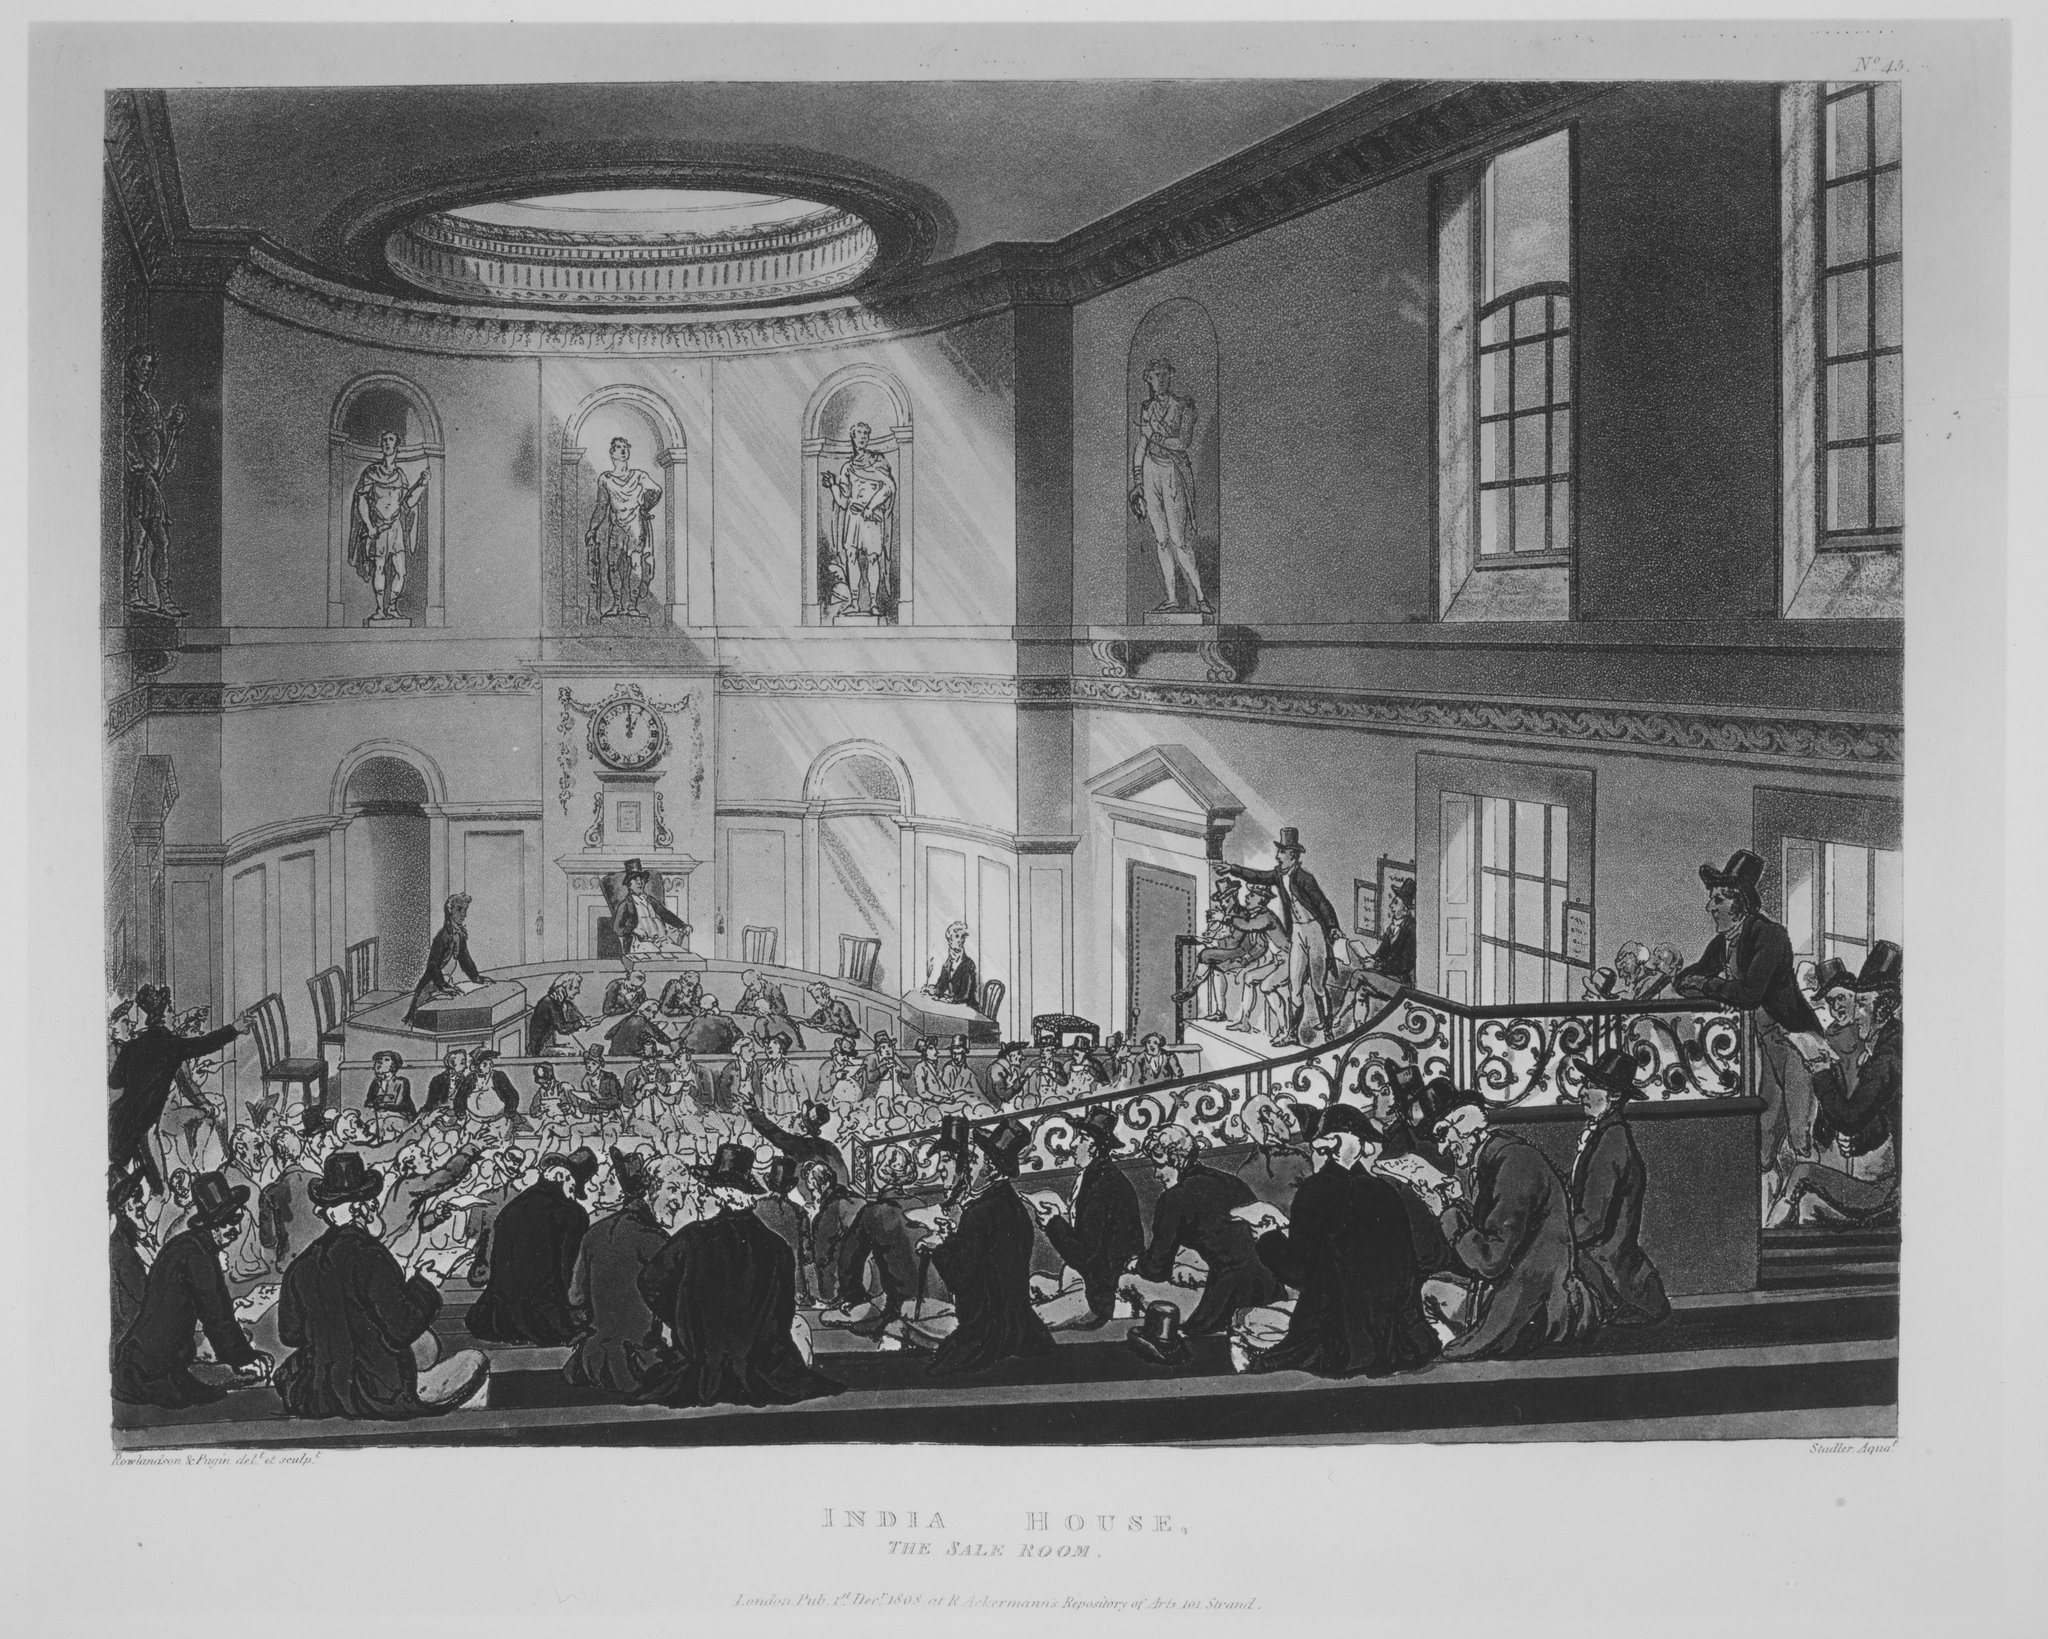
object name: book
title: The Microcosm of London, or London in Miniature, Vol. II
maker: william henry pyne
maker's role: author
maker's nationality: british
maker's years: 1770-1843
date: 1808-1811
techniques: aquatint, etching